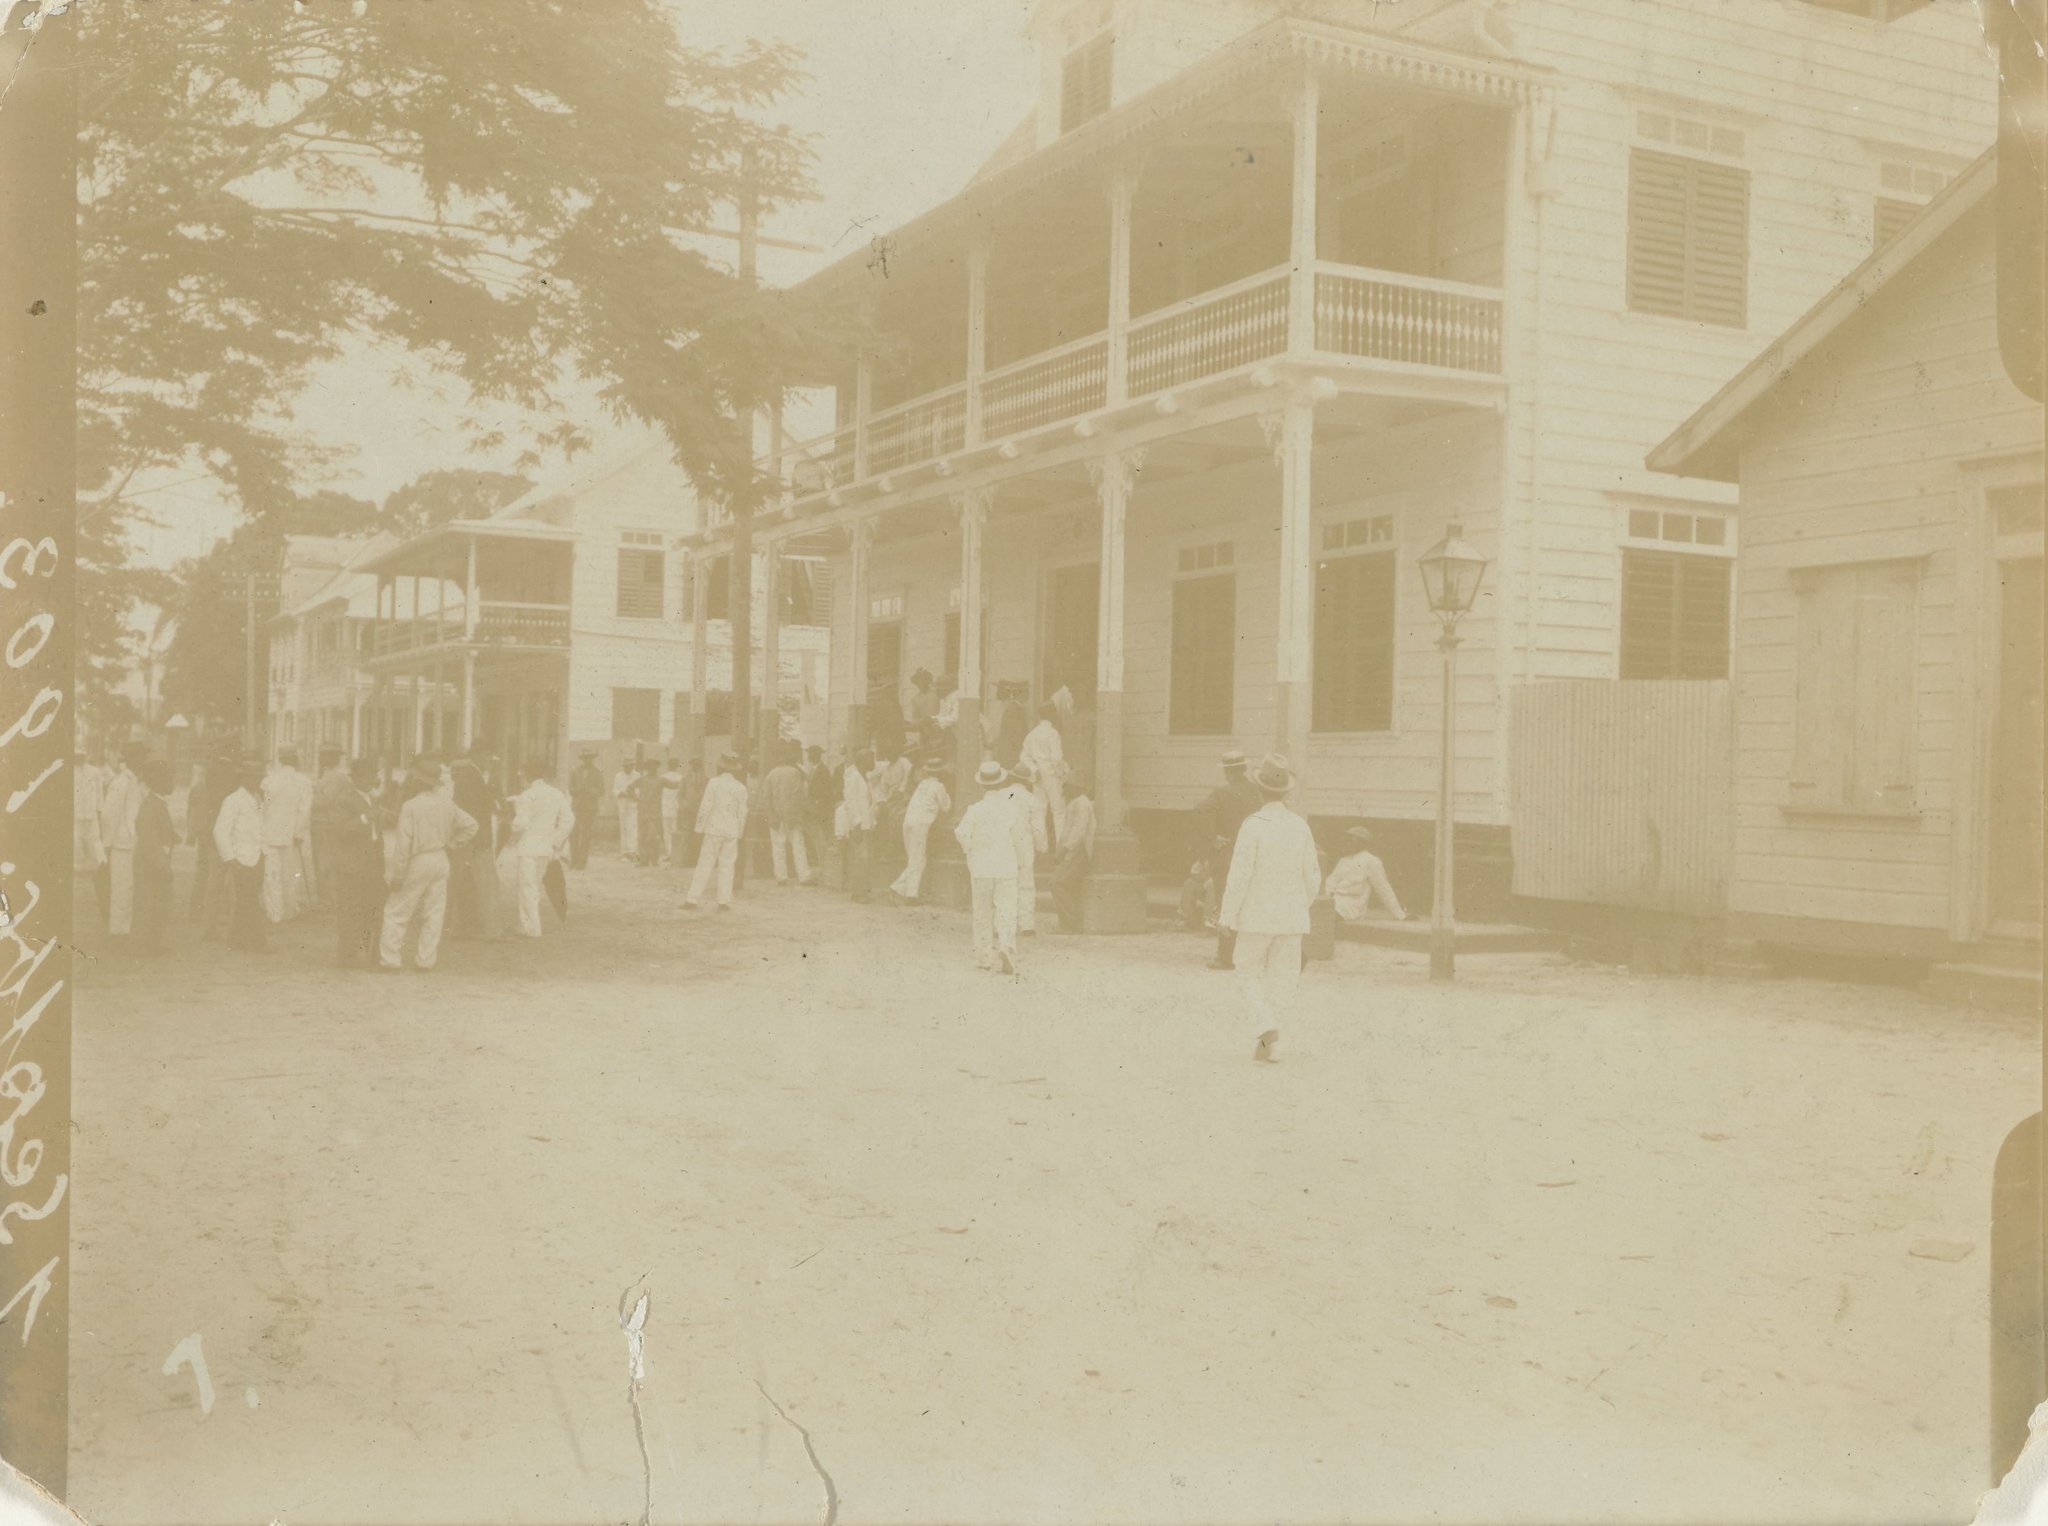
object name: photograph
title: Straatbeeld in Paramaribo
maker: Anonymous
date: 1903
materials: photographic support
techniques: photography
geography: paramaribo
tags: city-view in general; 'veduta'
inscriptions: date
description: Straatbeeld in Paramaribo met een groep mensen op straat voor een huis, 1903.